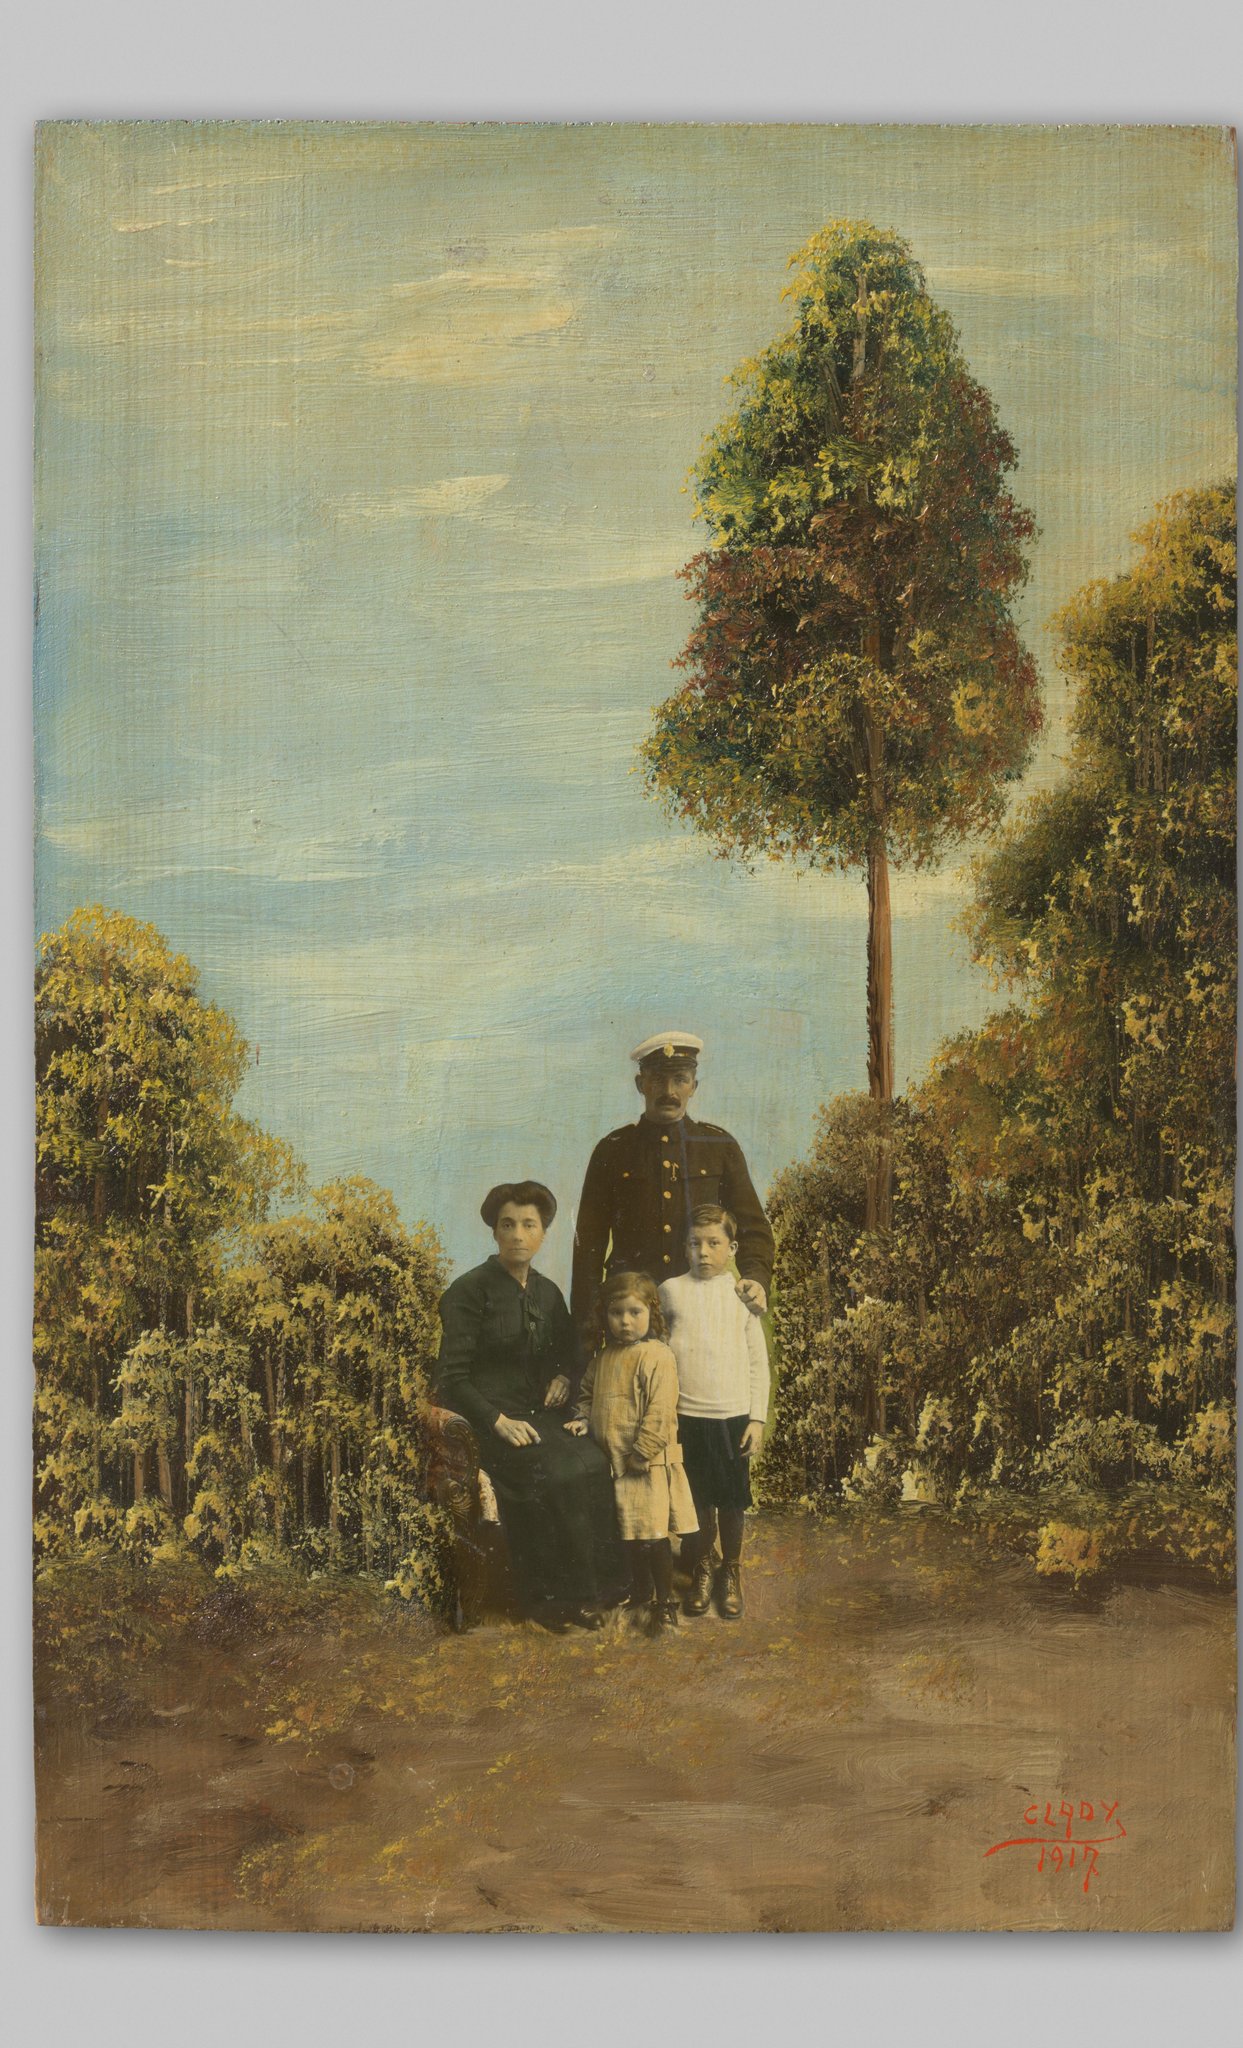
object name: panel ornament area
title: Portret van een onbekende man in marine-uniform, vrouw en twee kinderen in struikgewas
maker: clady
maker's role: fotograaf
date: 1917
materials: paint, paper, wood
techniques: albumen print, brush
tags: adult woman, adult man, child, anonymous historical person portrayed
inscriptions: address: ‘Mon CLADY/ Rue des Hêtres/ GRAYVILLE-SAINTE-HONORINE/ Seine a Inf.’